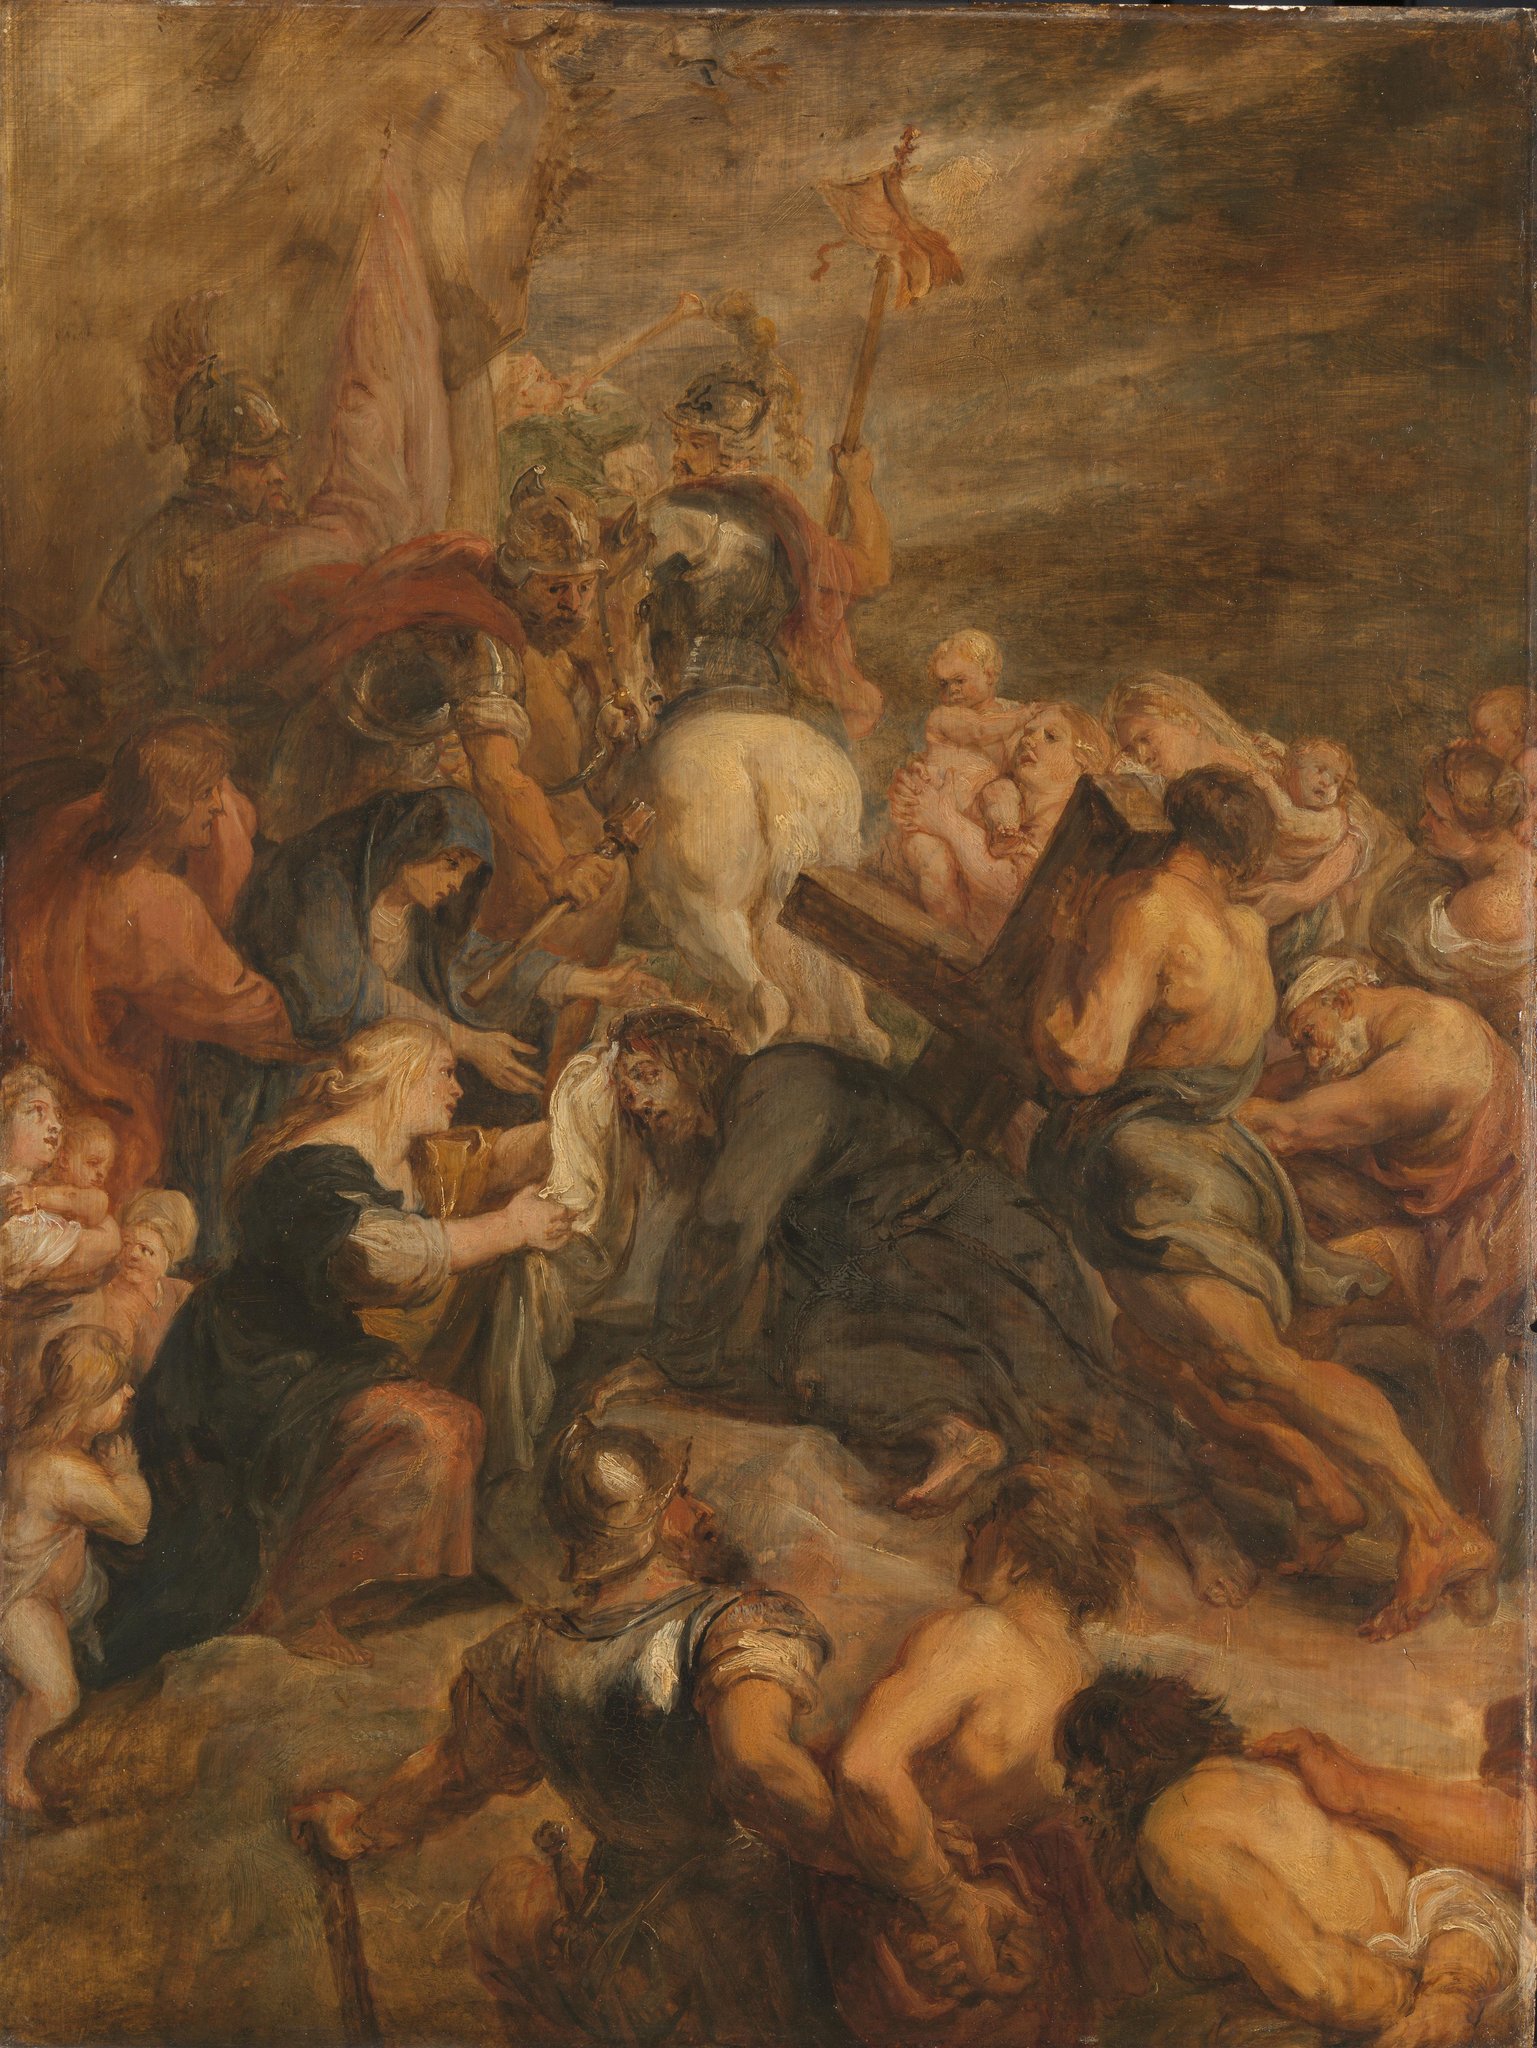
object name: painting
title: Christ on the Way to Calvary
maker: peter paul rubens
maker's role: draughtsman, painter, print maker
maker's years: 1577-1640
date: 1635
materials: oil, panel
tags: carrying of the cross: christ bearing the cross, alone or with the help of others (e.g. simon the cyrenian)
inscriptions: mark, indistinct, on the reverse, branded: coat of arms of the city of Antwerp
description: Peter Paul Rubens (1577 - 1640). Christ Carrying the Cross, c. 1635. This quick sketch, painted with oil, is a design for a 5.5 metre high altarpiece made by Rubens between 1634 and 1637 for the Benedictine Abbey at Affligem in Flemish Brabant, and currently in a Brussels museum. Three oil sketches for the altar have survived. Rubens focused the viewer's attention on the centre of the composition. Jesus collapsing under the cross. Veronica wipes his face with a cloth. The figures are depicted in a diagonal composition that rises from the prisoners below right to the soldiers top left. This arrangement enabled Rubens to group the various characters in a convincing whole, creating a suggestion of movement and depth. Purchased in 1809, from the collection Van Heteren Gevers (The Hague).